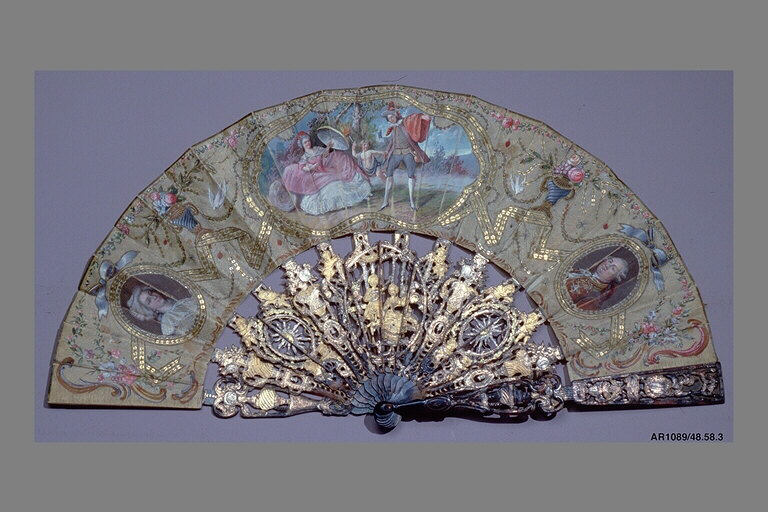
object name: fan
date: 1776-1800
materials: gold leaf, paper, silk, silver, shell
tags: men,portraits,women